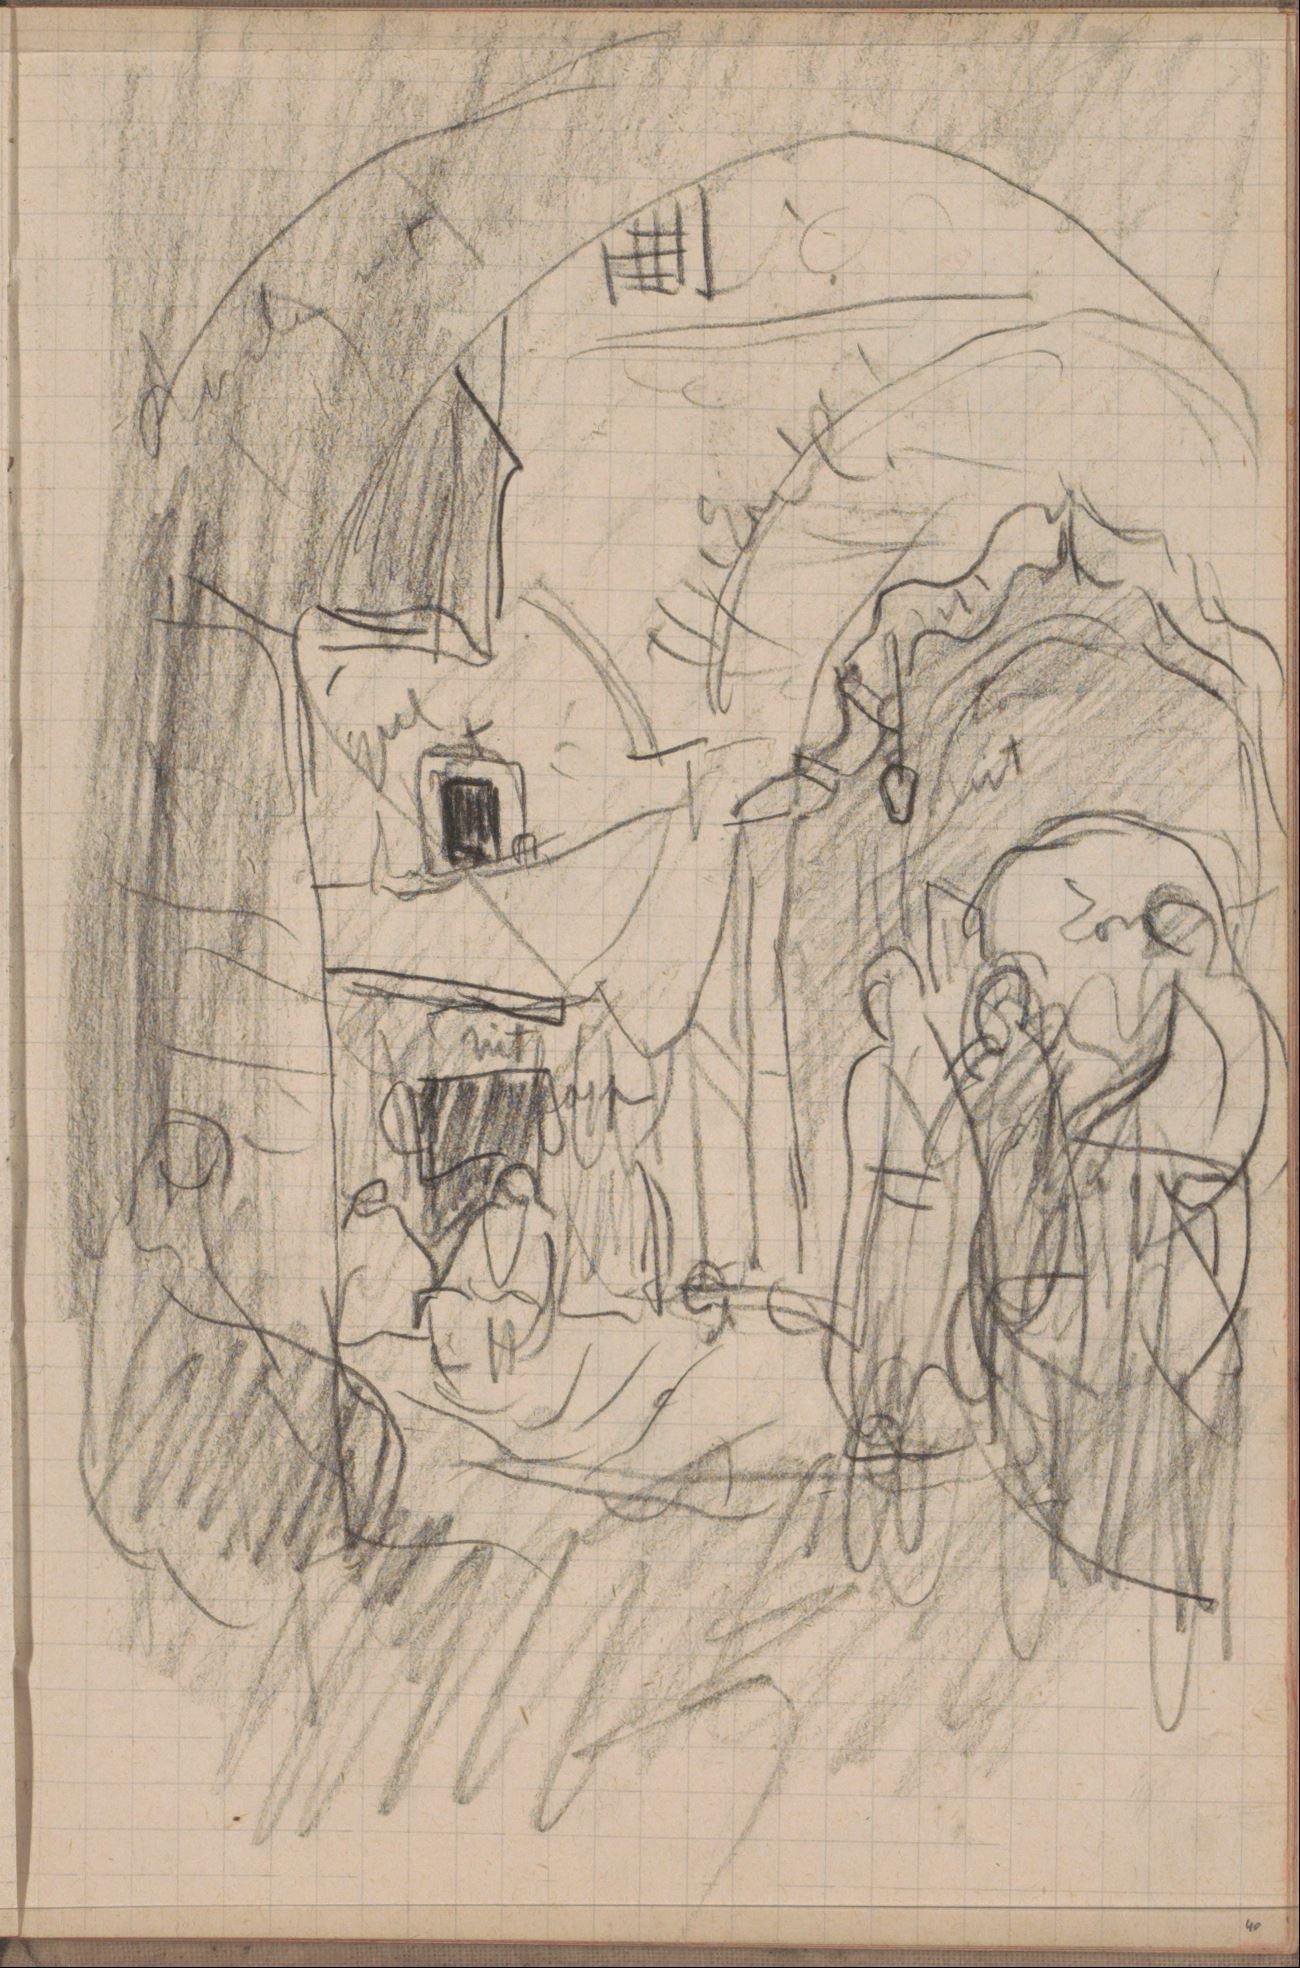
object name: sketchbook leaf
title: Straat en figuren gezien door een portaal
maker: marius bauer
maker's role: draughtsman, print maker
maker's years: 1867-1932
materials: chalk, paper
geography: istanbul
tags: arch, archivolt ~ architecture, street (+ city(-scape) with figures, staffage)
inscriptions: kleurnotitie, handgeschreven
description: De figuren zijn zittend en staand weergegeven. Pagina 40 uit een schetsboek met 51 bladen.